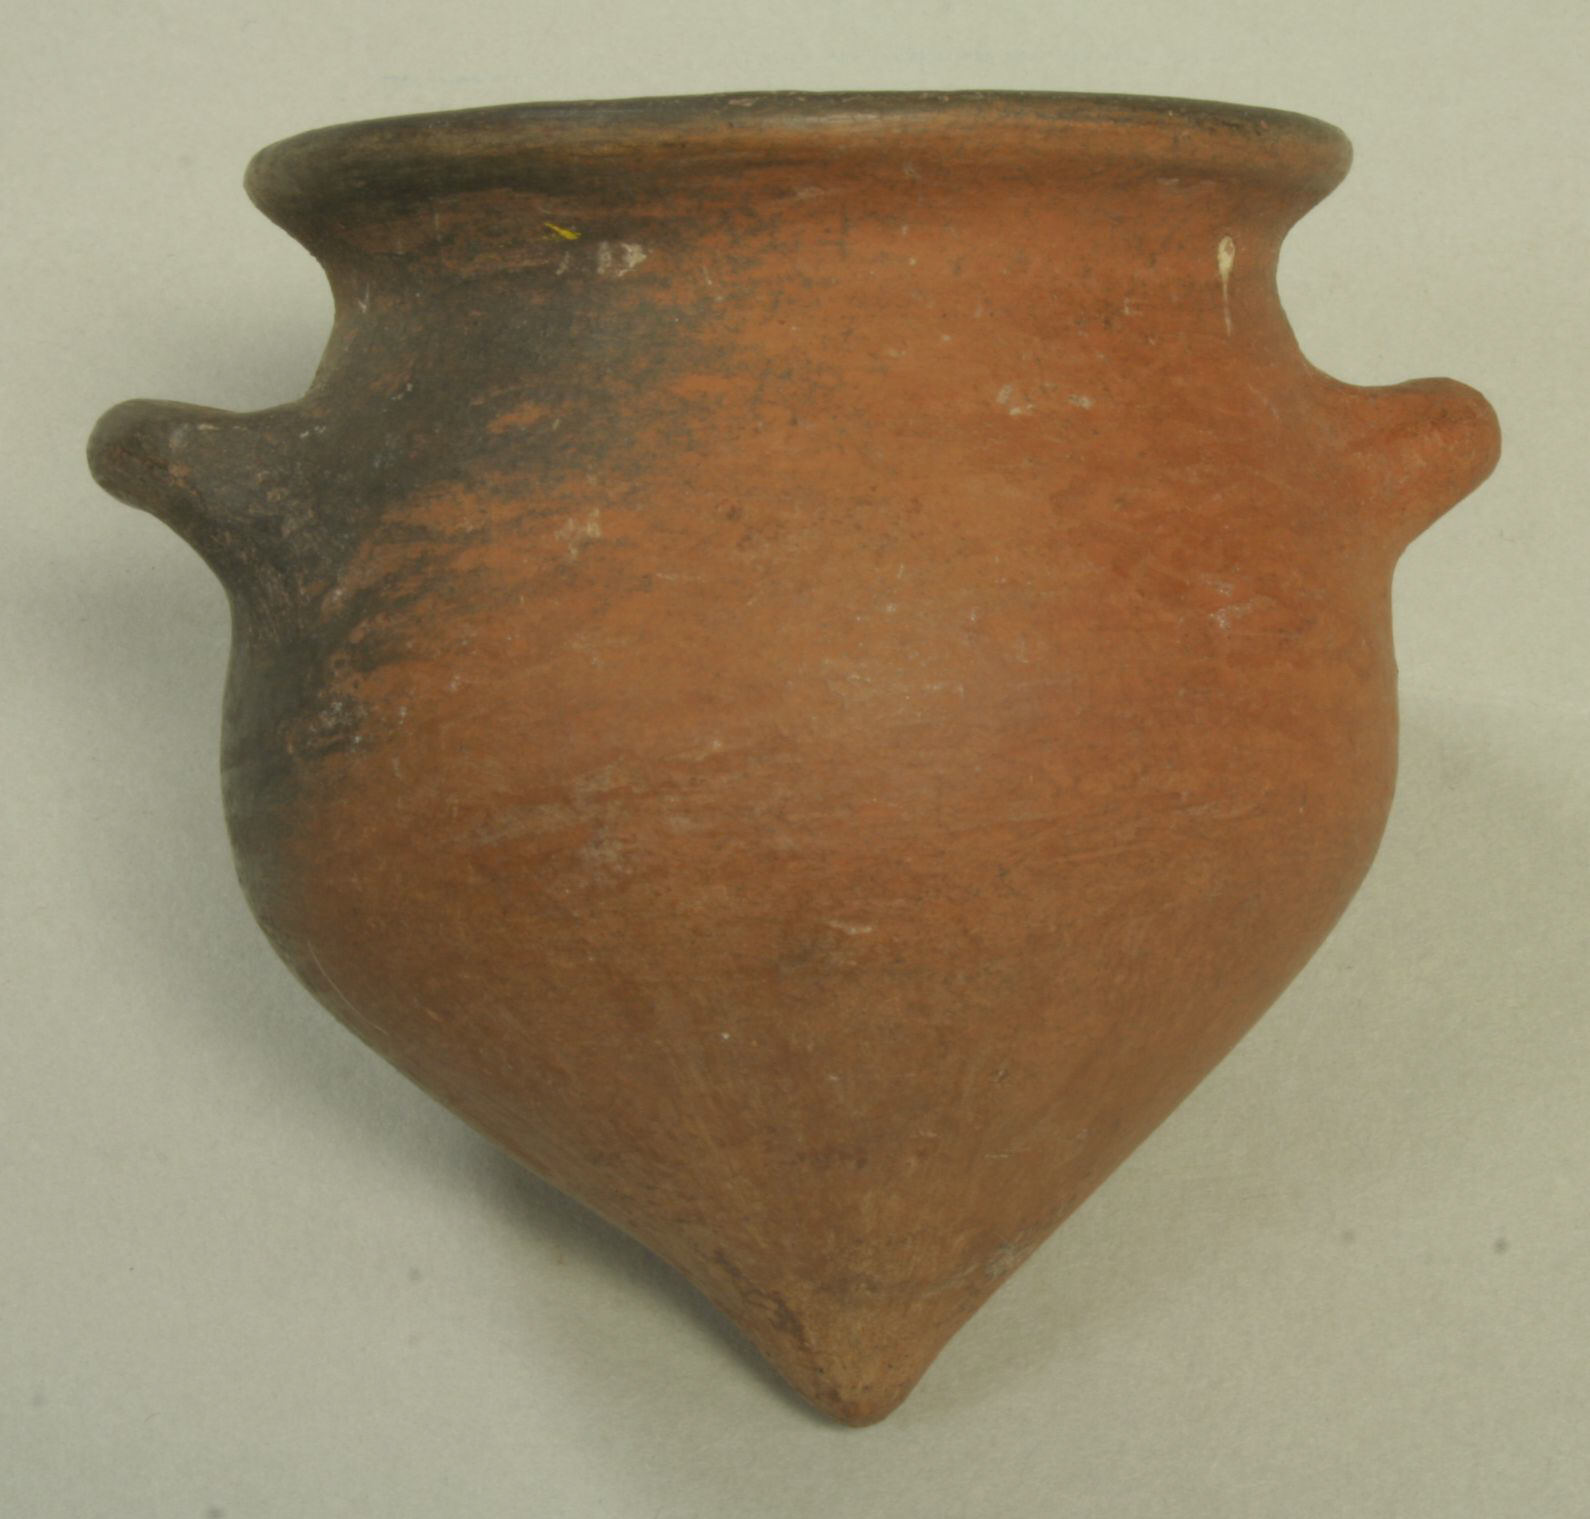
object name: jar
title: Miniature Jar with Two Handles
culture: inca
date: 1401-1533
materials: ceramic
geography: peru